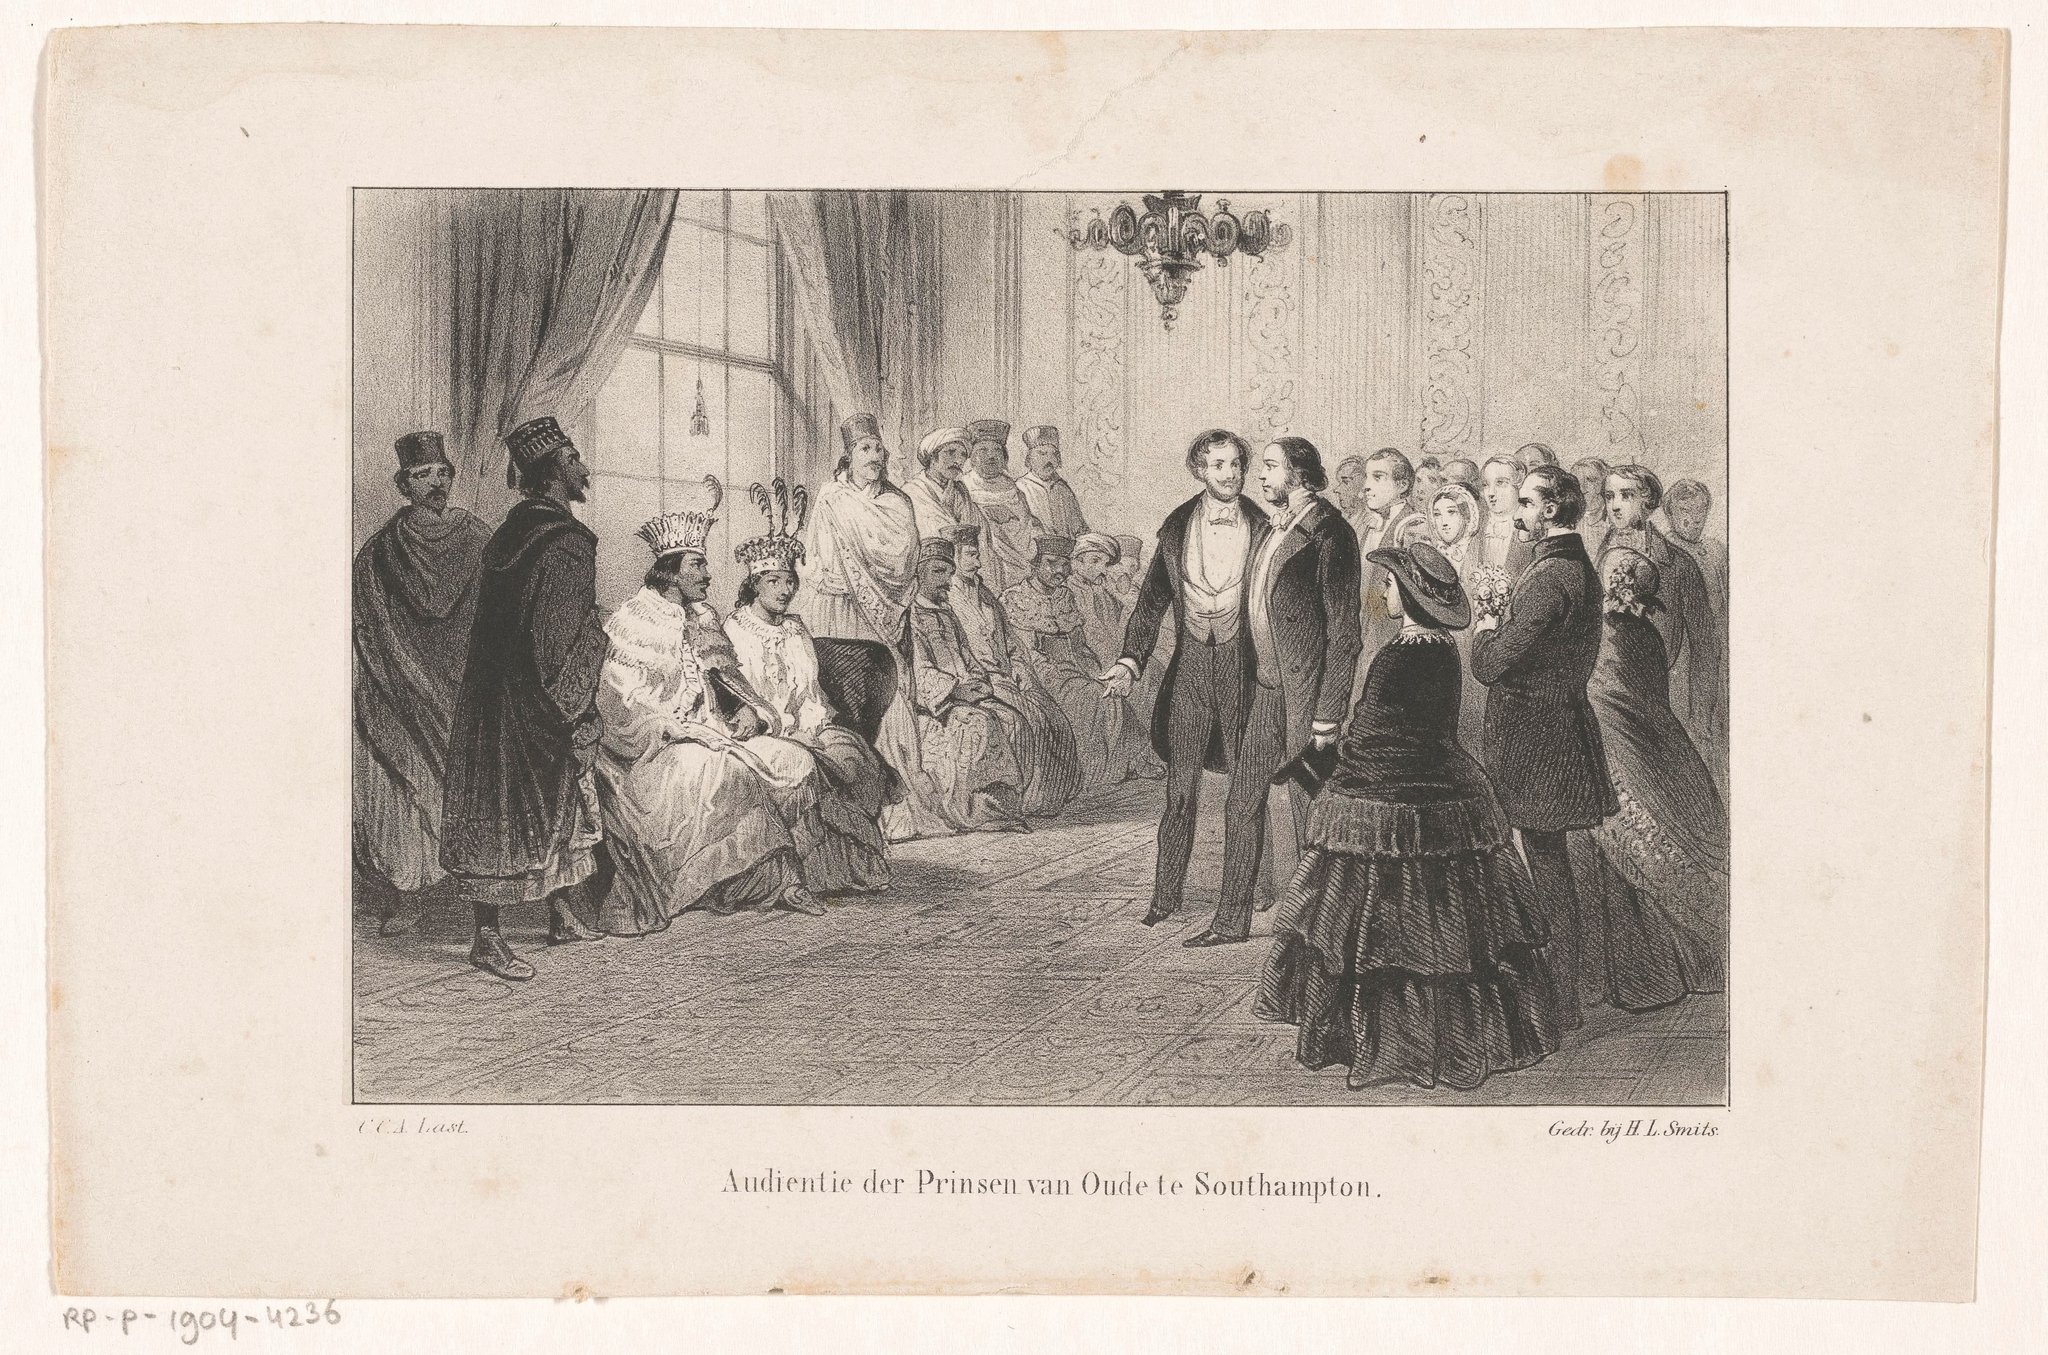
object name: print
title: Audientie der Prinsen van Oude te Southampton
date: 1818-1876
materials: paper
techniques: lithograph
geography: the hague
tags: audition; ruler giving audience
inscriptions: collector's mark: Lugt 2228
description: Voor het raam zitten een koning en koningin. Zij dragen beiden een kroon met veren. Naast hen leden an hun hofhouding. Tegenover hen staan mannen en vrouwen.